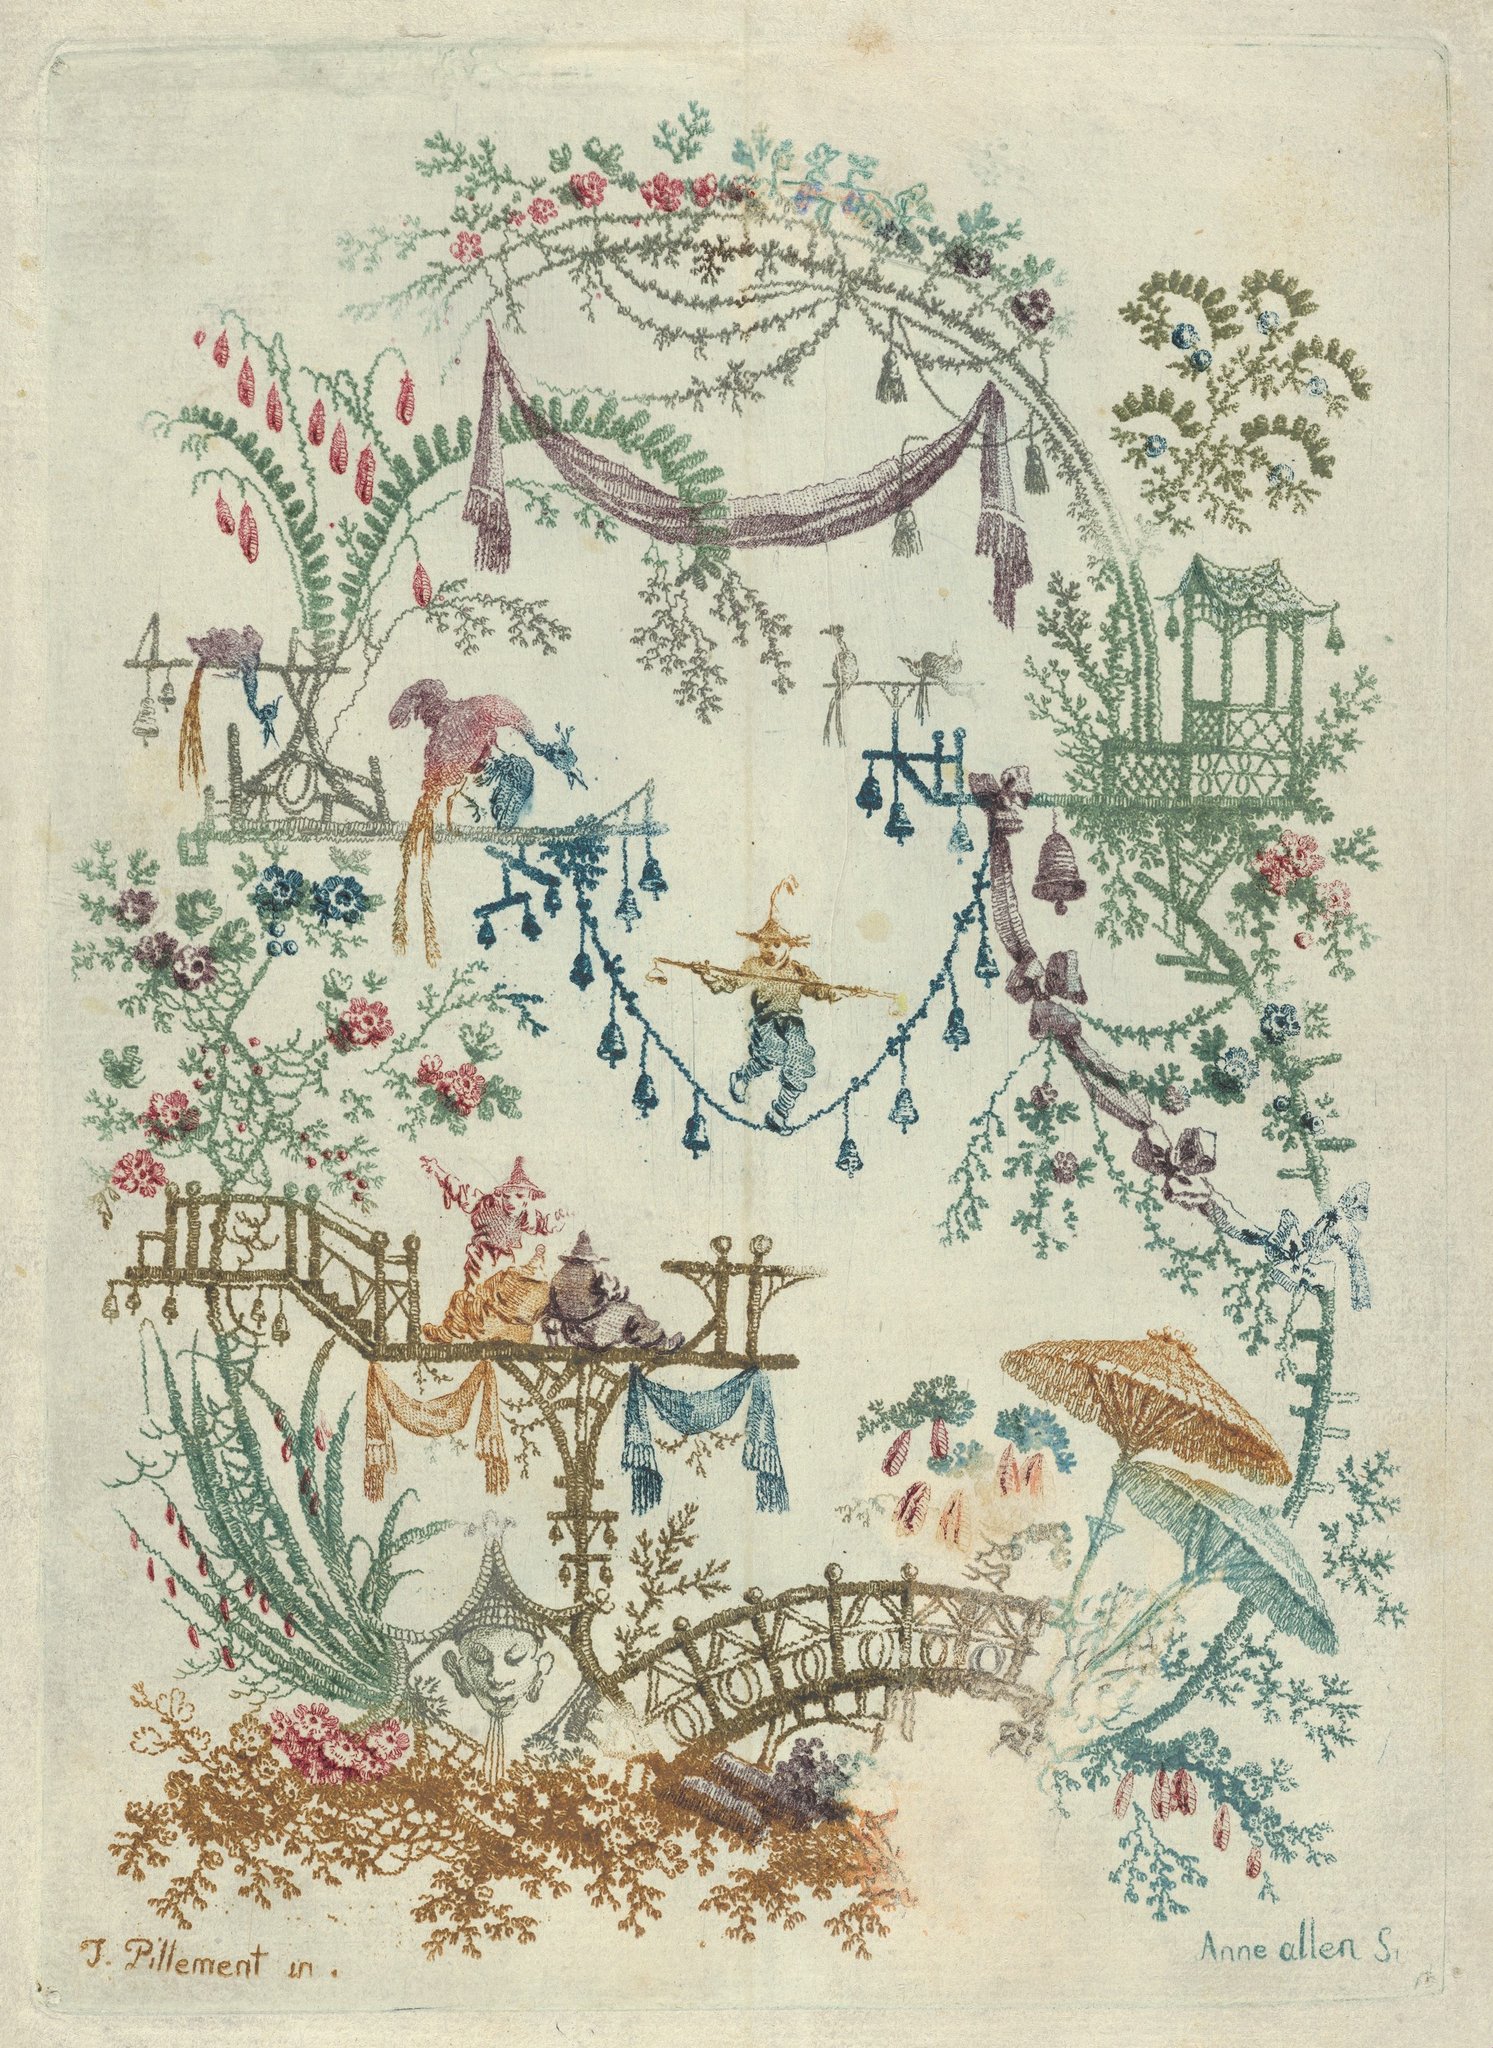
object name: print ornament architecture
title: Chinoiserie, from "Nouvelle Suite de Cahiers arabesques chinois a l'usage des dessinateurs et des peintres"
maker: jean pillement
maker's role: artist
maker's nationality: french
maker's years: 1728-1808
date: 1790-1799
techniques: etching, lithography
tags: birds,chinoiserie,men,flowers